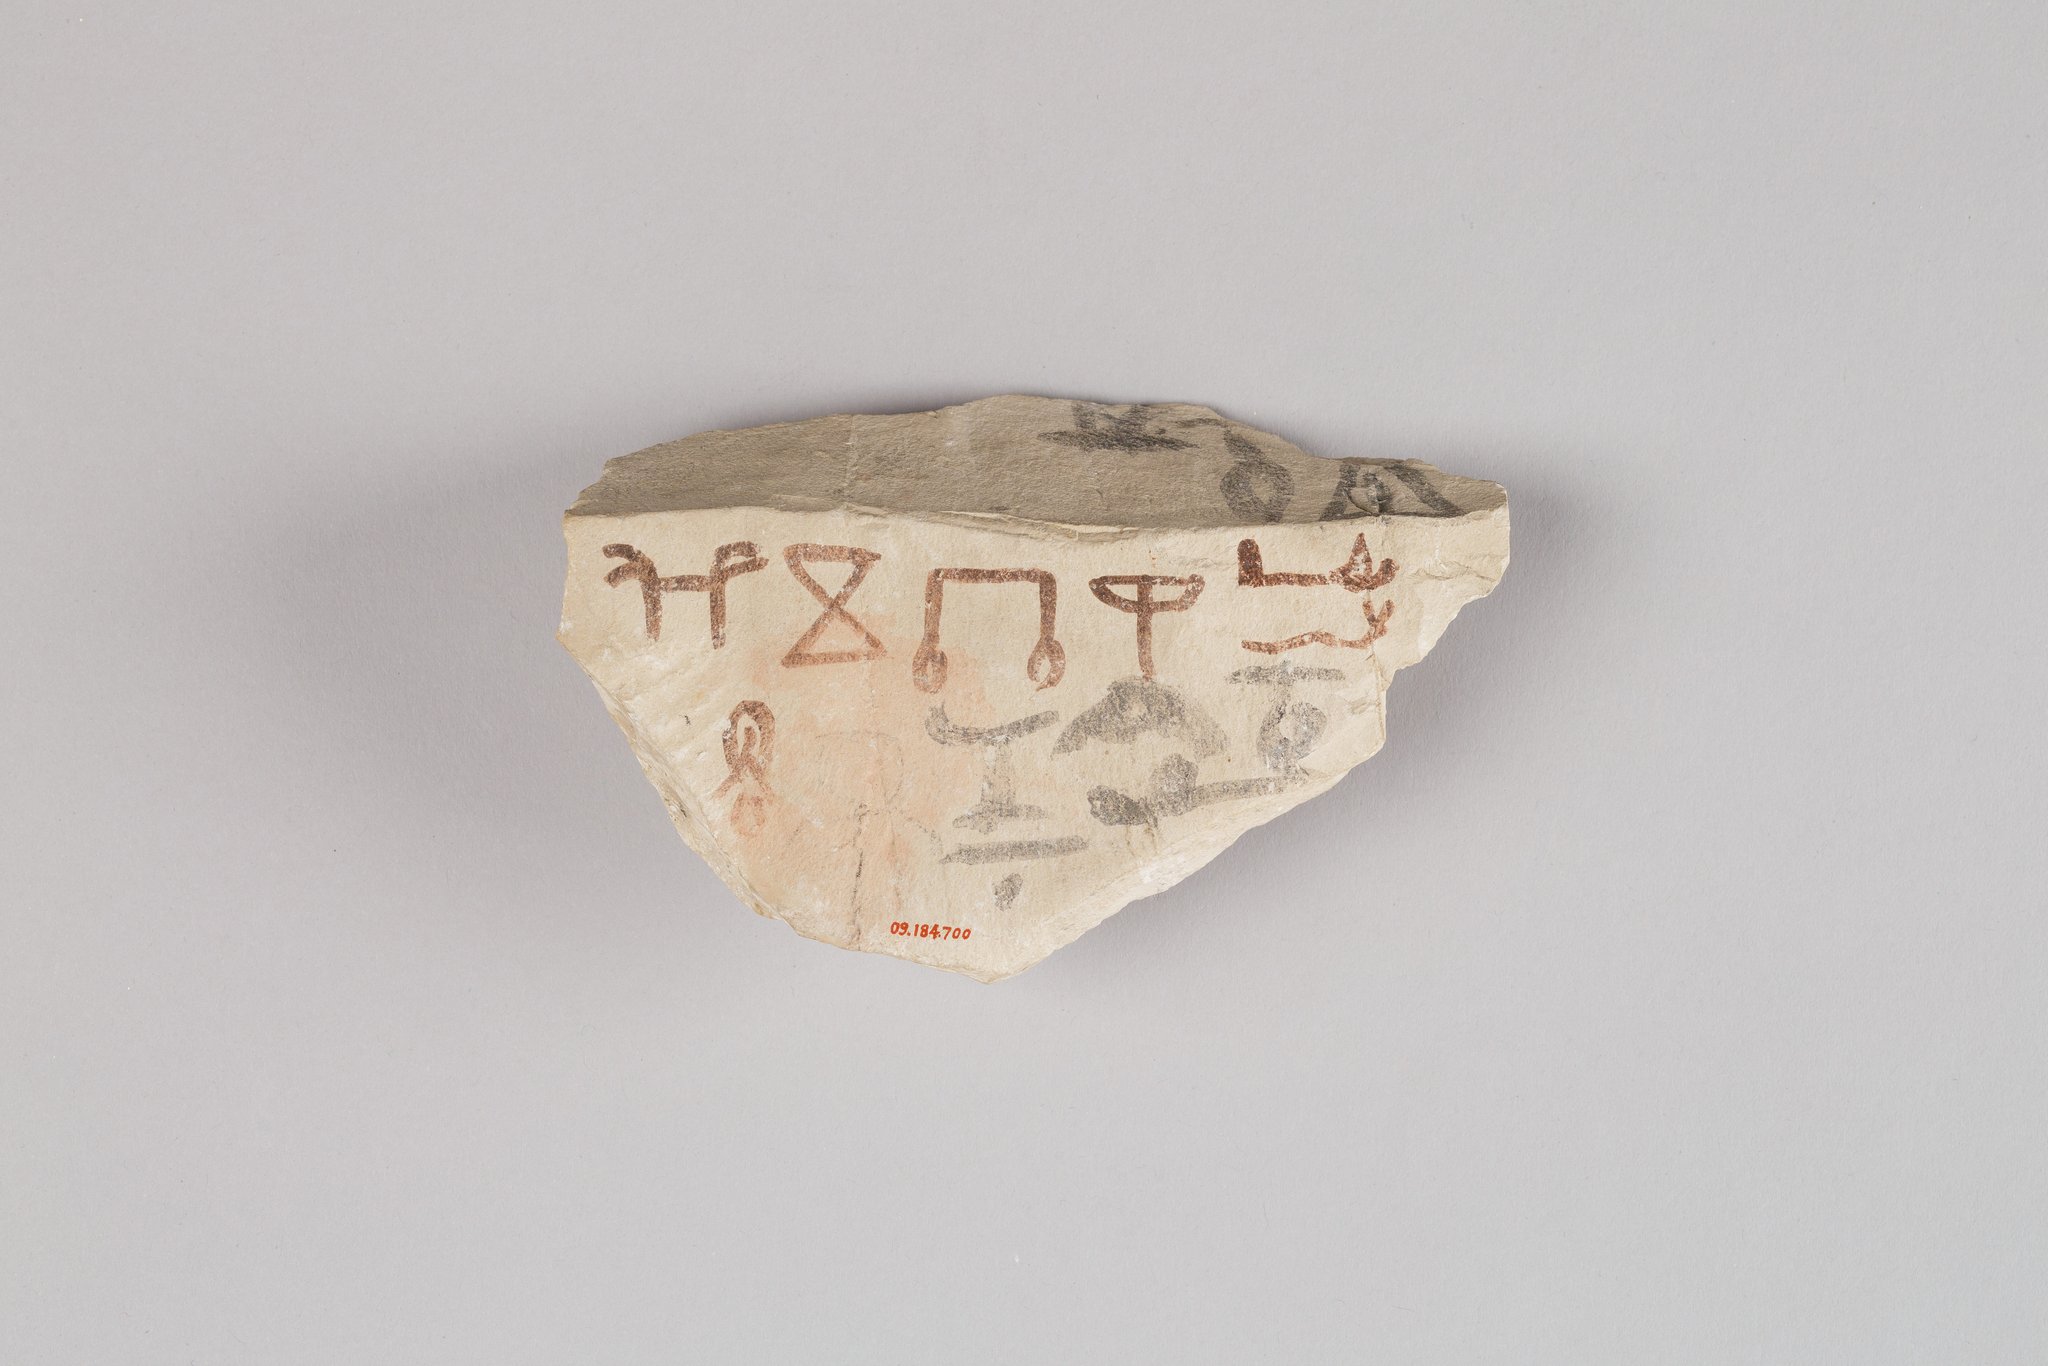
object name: ostracon, hieroglyphic, workmen's identity marker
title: Ostracon with Workmen's Identity Marks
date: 1390-1352 BCE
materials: ink, limestone, paint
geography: egypt